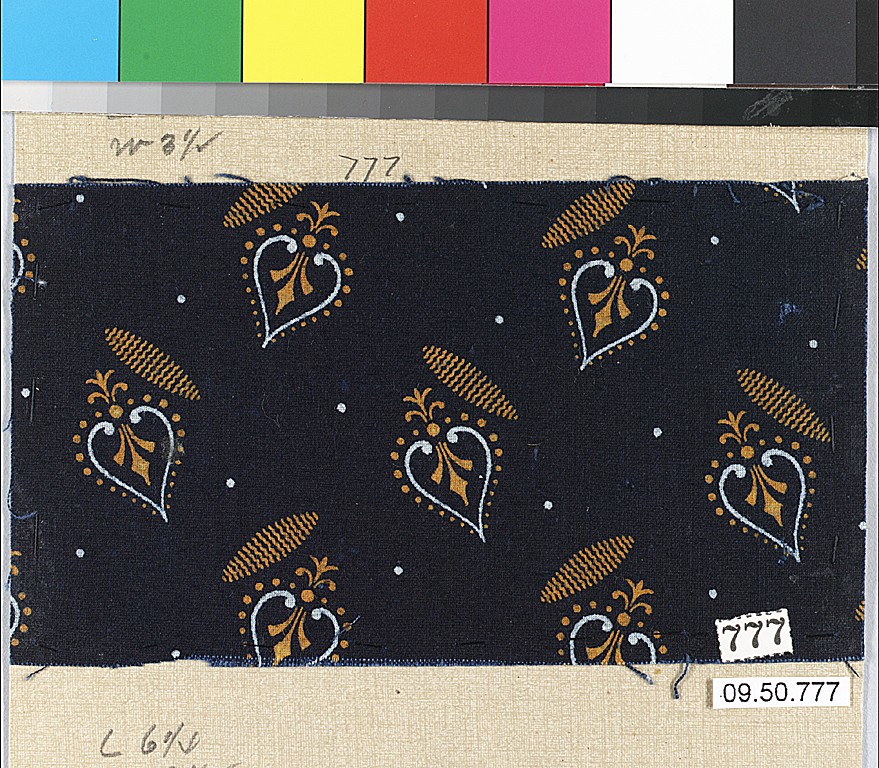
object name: piece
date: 1801-1900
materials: cotton